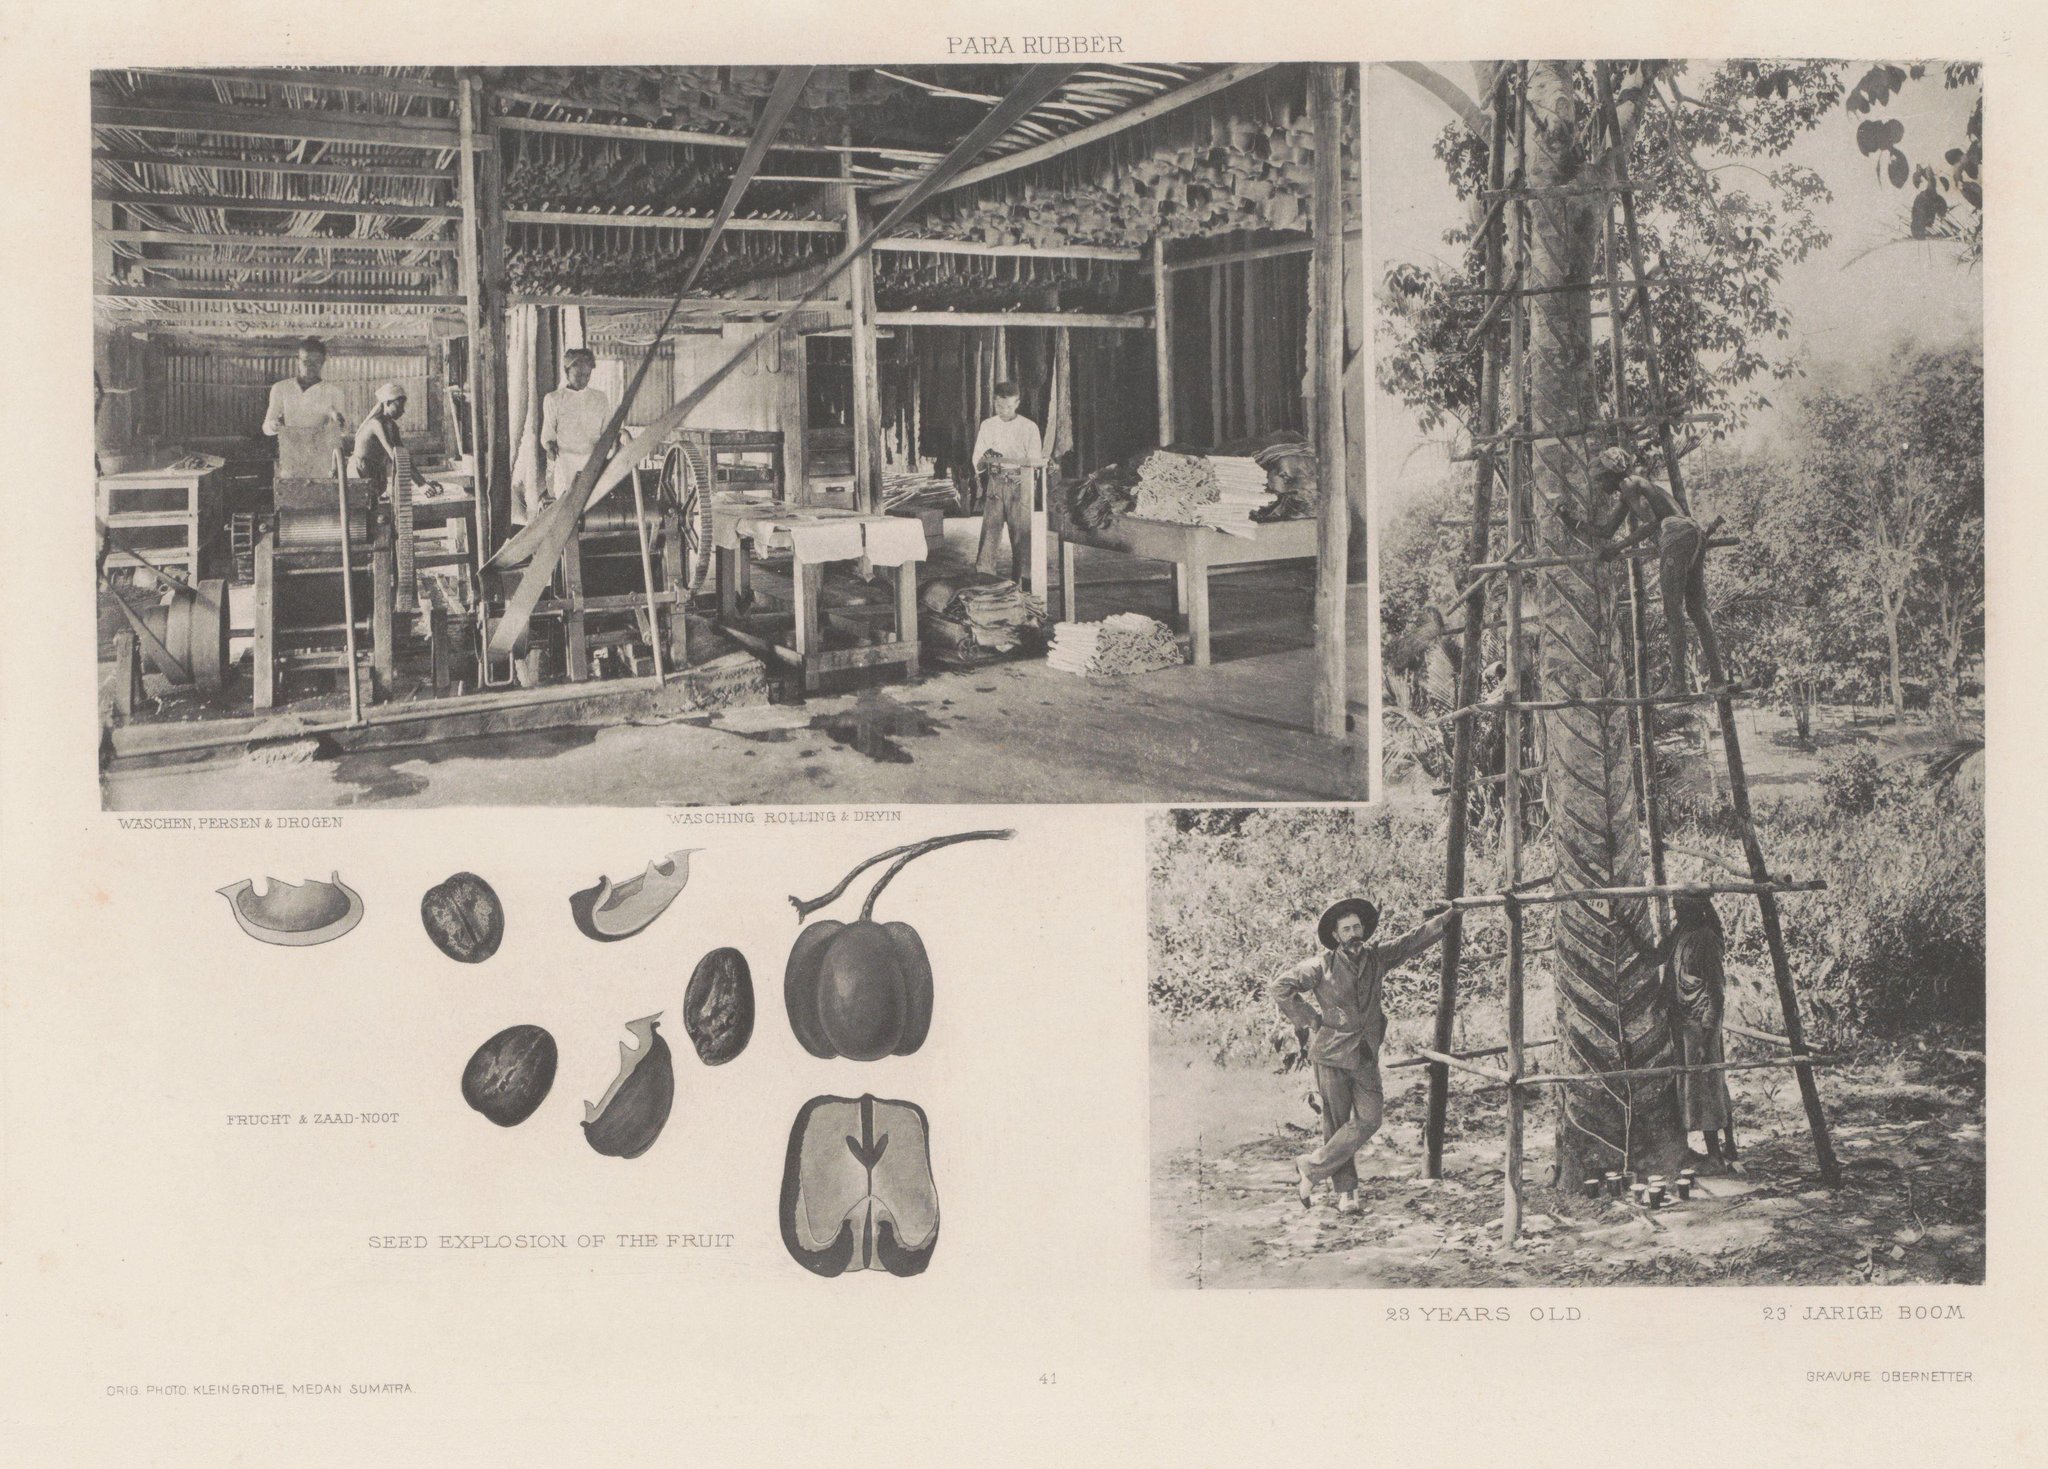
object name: photomechanical print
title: Waschen, persen & drogen (linksboven), frucht & zaad-noot, (linksonder), 23 jarige boom (rechts)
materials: paper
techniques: photoaquatint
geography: munich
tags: plantation, (non-fruit) products of plants or trees: rubber, sumatra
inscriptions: number: ‘41’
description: Onderdeel van Album met heliogravures van Sumatra's oostkust.